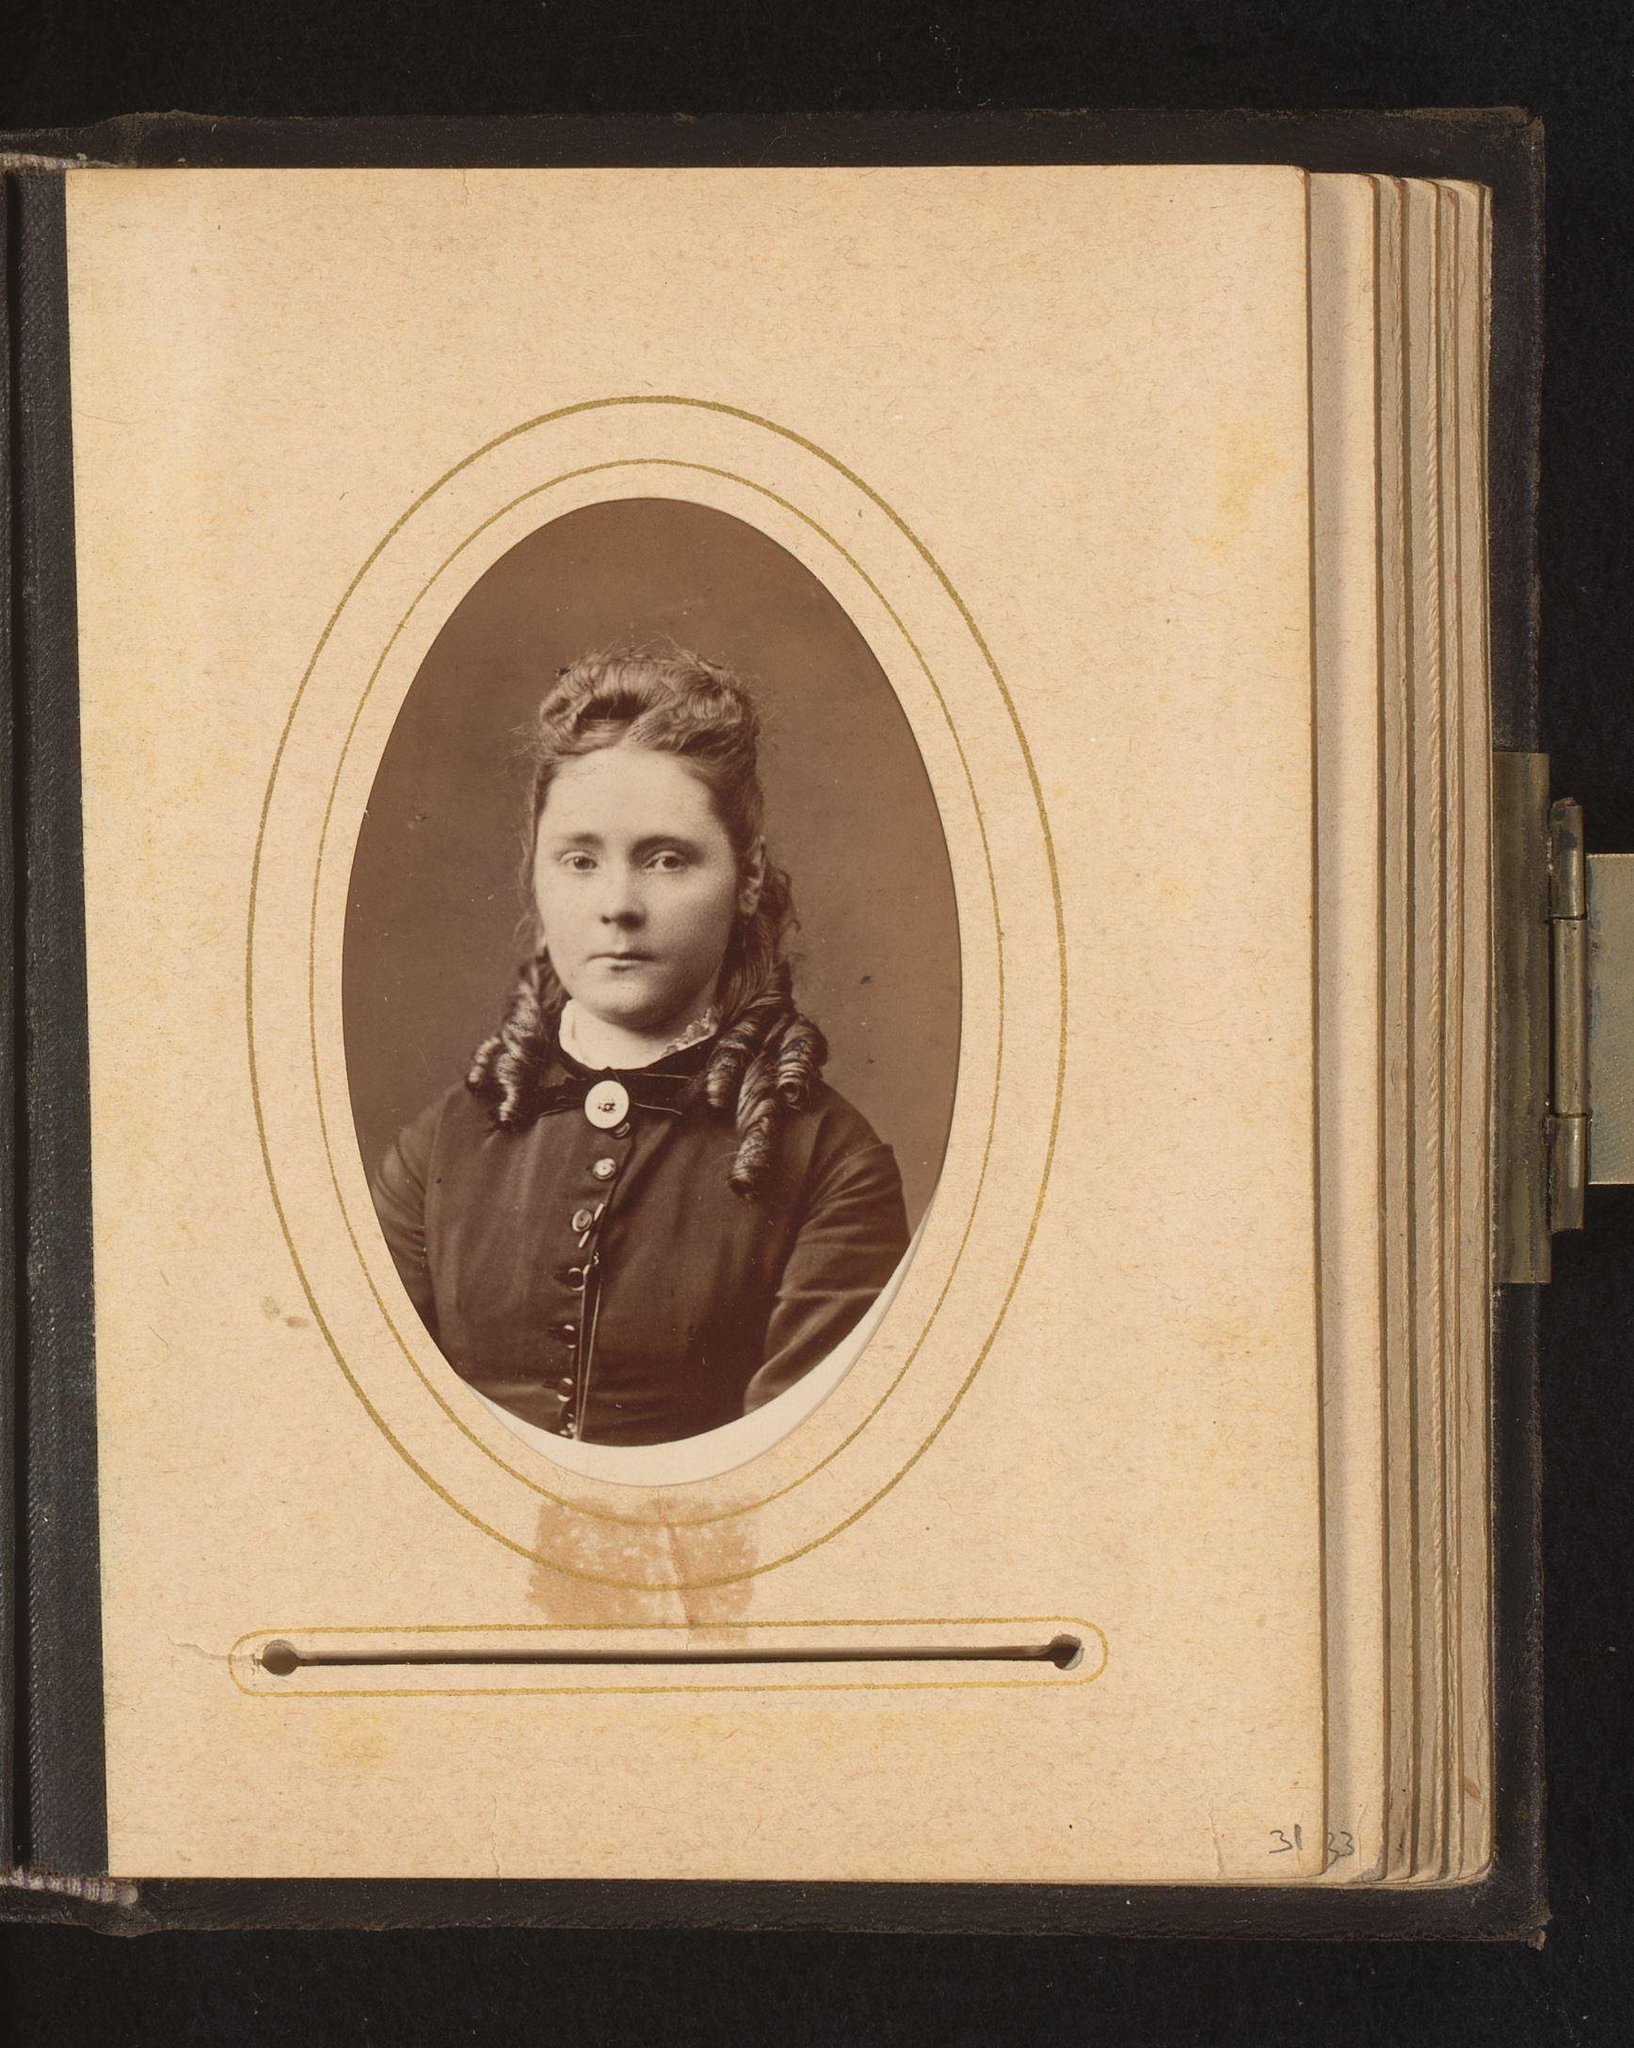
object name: carte de visite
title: Portret van een meisje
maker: bernardus bruining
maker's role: fotograaf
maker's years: 1834-1900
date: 1860-1890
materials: cardboard, photographic support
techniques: albumen print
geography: leiden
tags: girl (child between toddler and youth)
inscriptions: inscription: ‘B. Bruining/ Photographe/ van Z.K.H. prins Frederik der Nederlanden te Leiden’